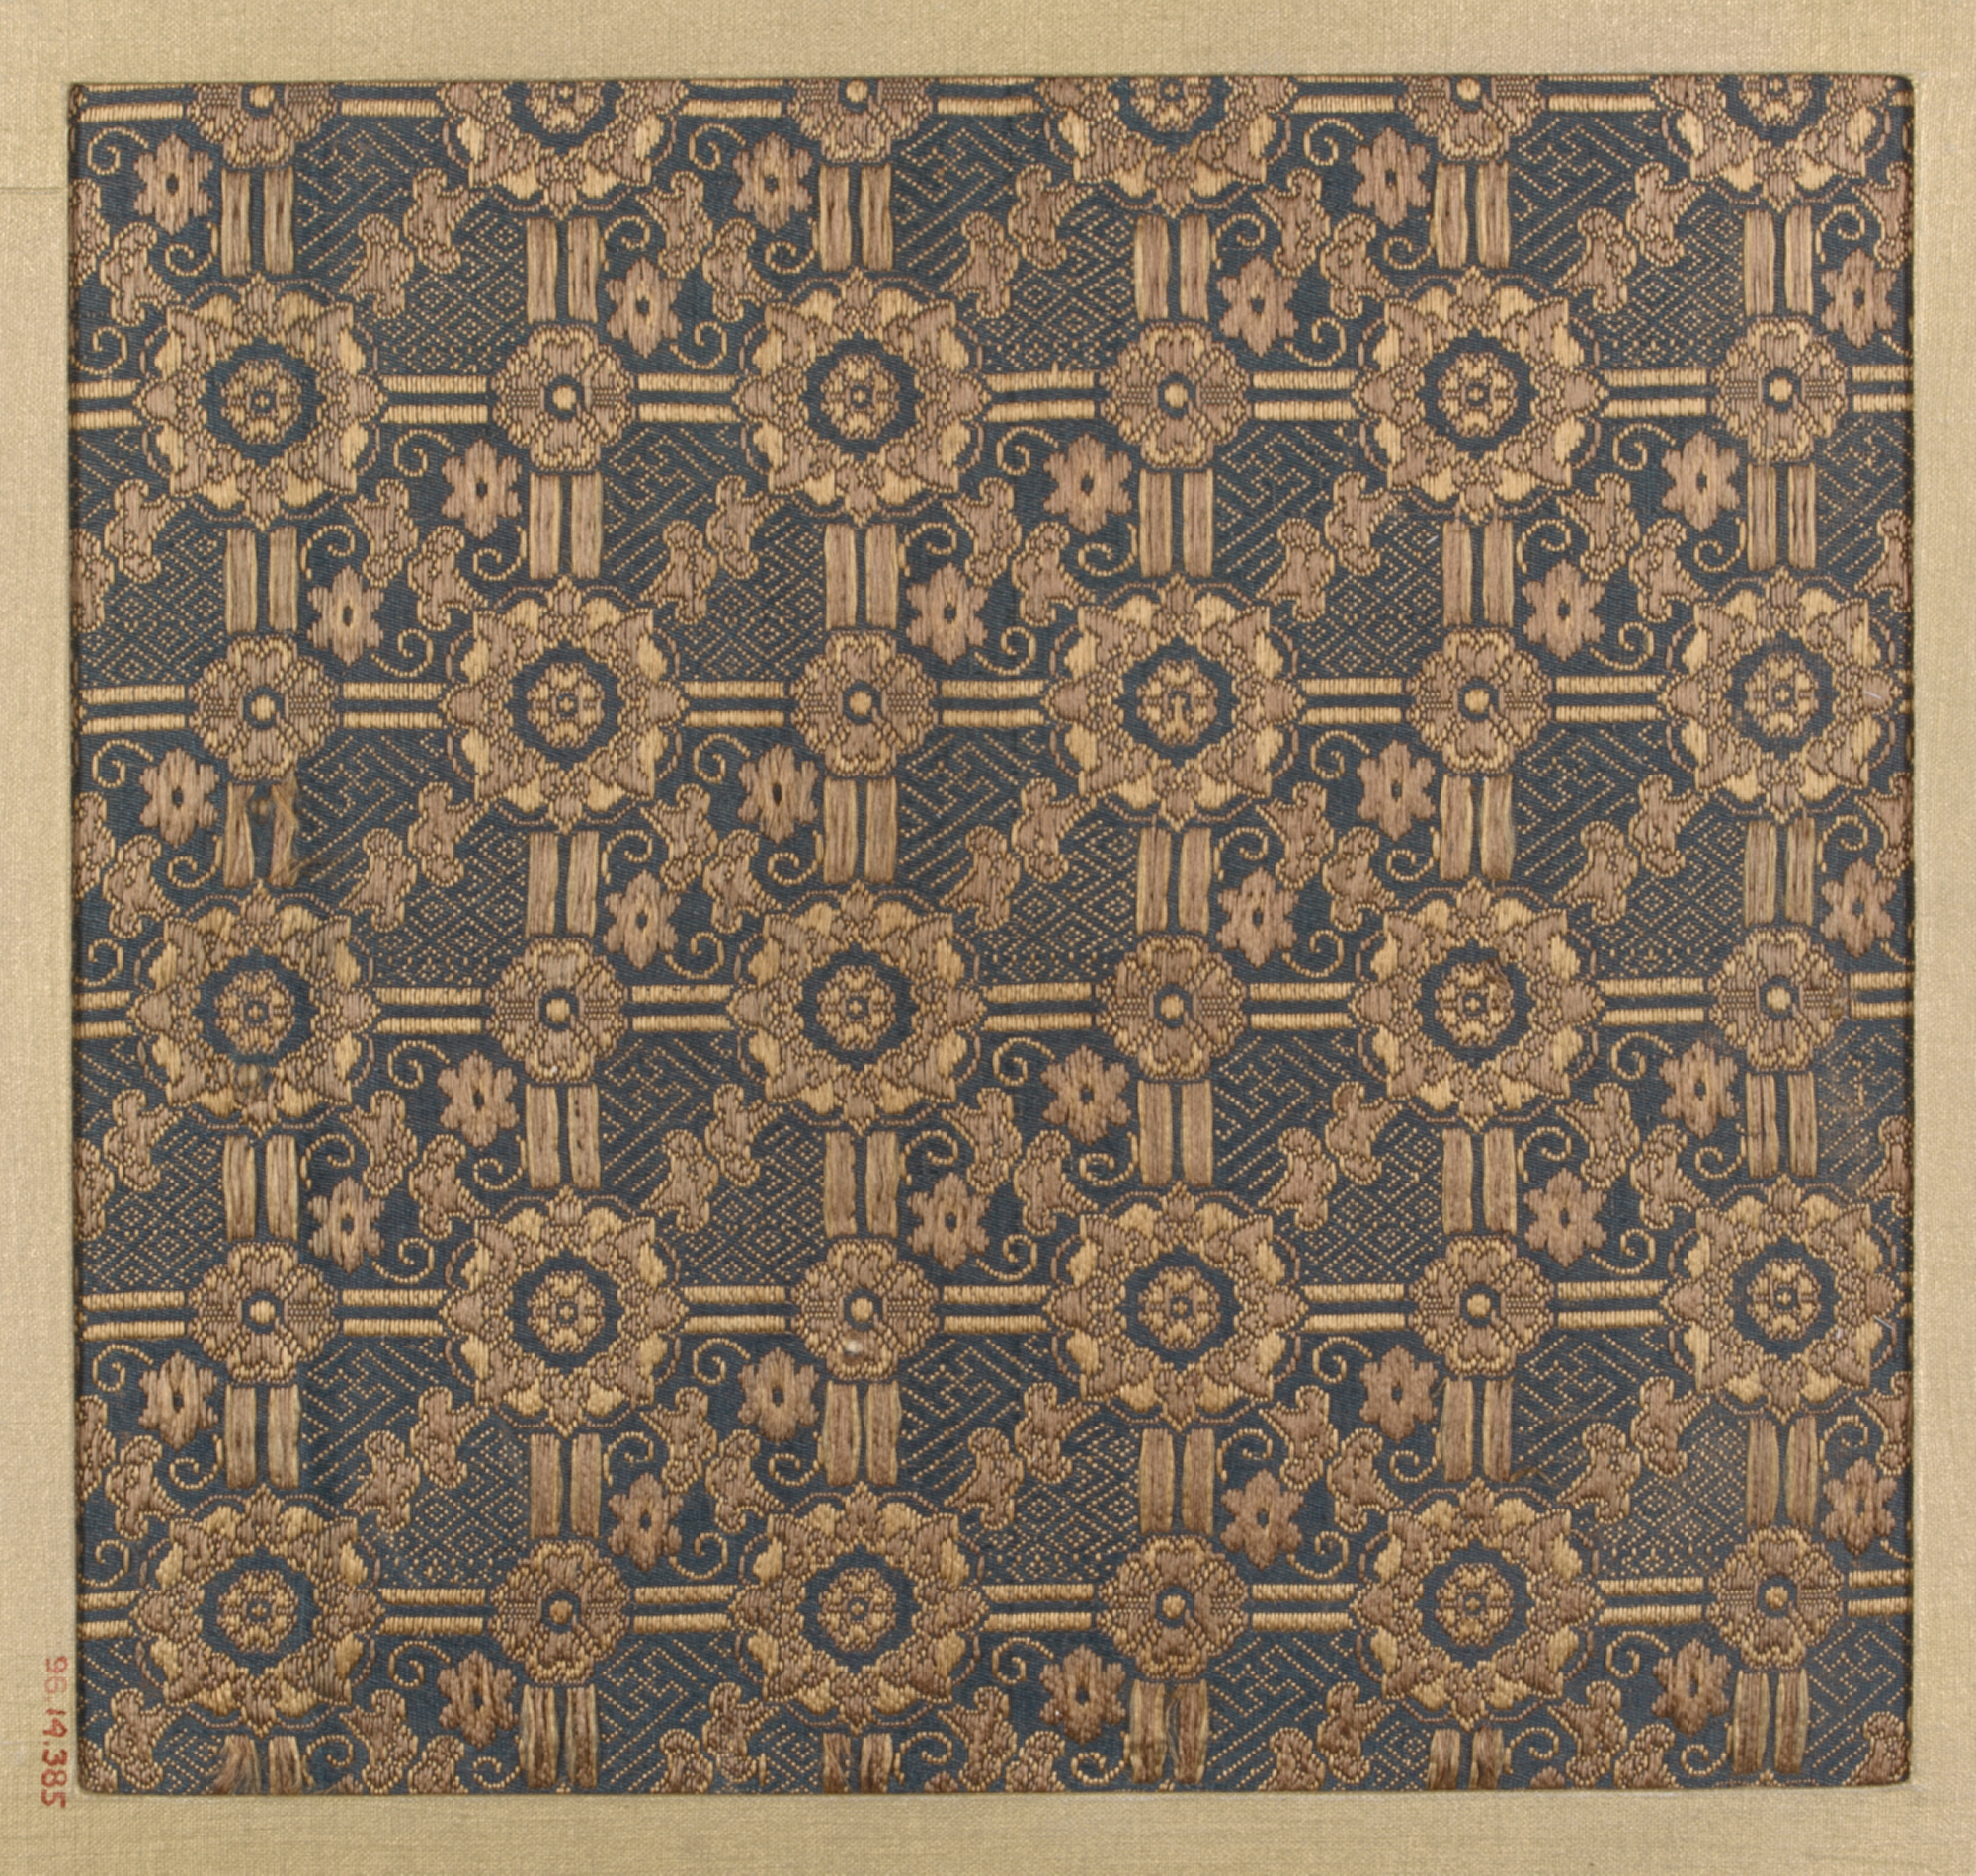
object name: piece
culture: japanese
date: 1701-1900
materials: silk